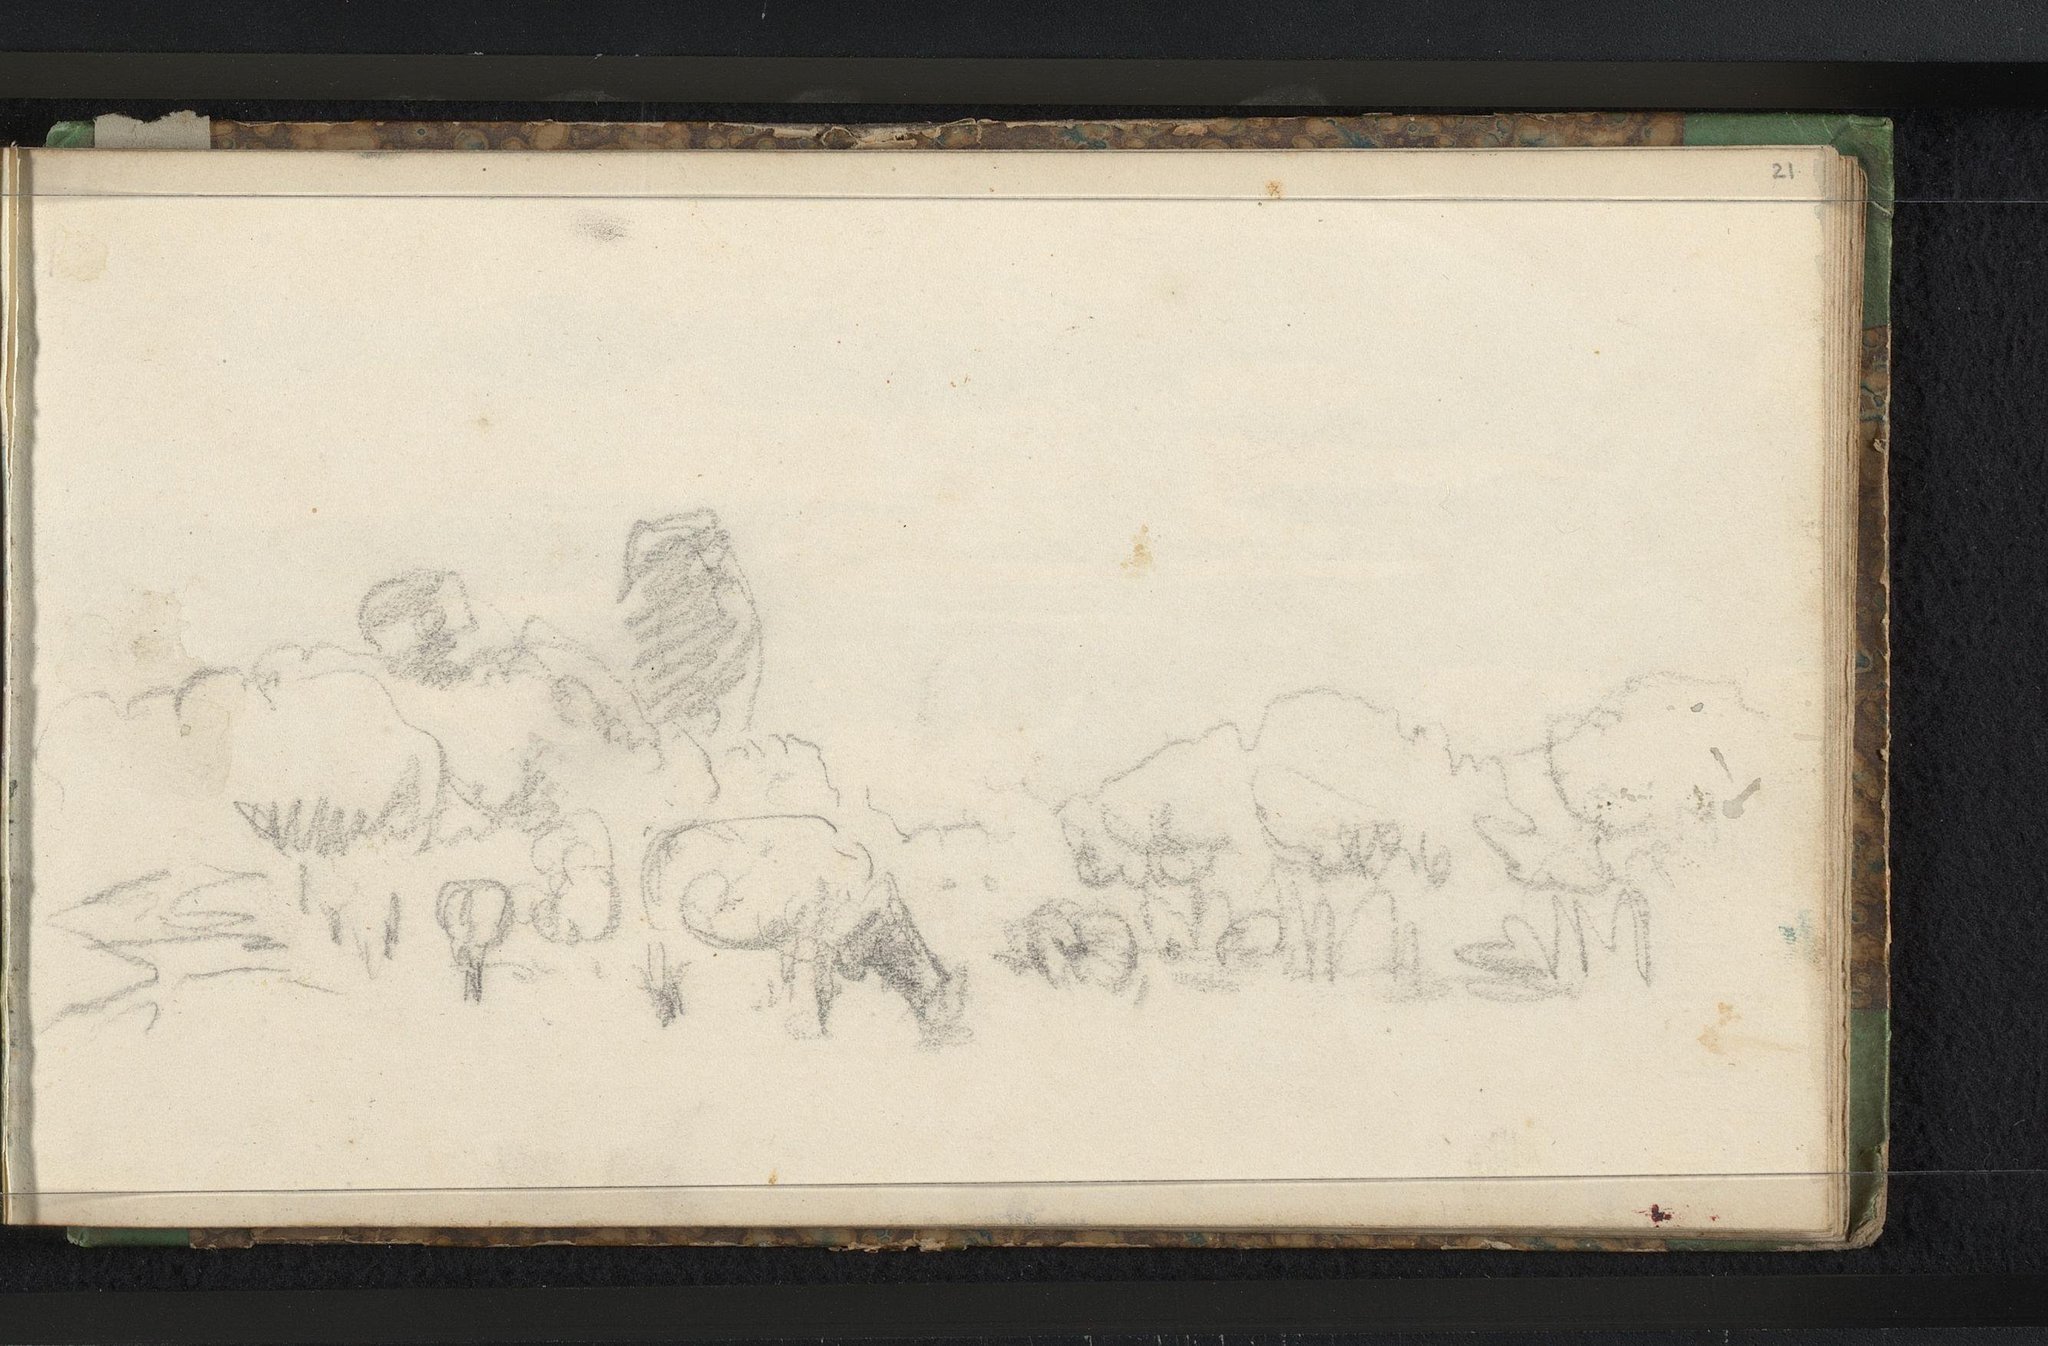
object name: sketchbook leaf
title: Weiland met vee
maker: jan bedijs tom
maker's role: draughtsman, painter, print maker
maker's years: 1813-1894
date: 1828-1894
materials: paper, pencil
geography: the hague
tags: trees, landscapes, cattle, artist (in general) making preliminary designs, sketching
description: Pagina 21 recto uit een schetsboek met 50 bladen.